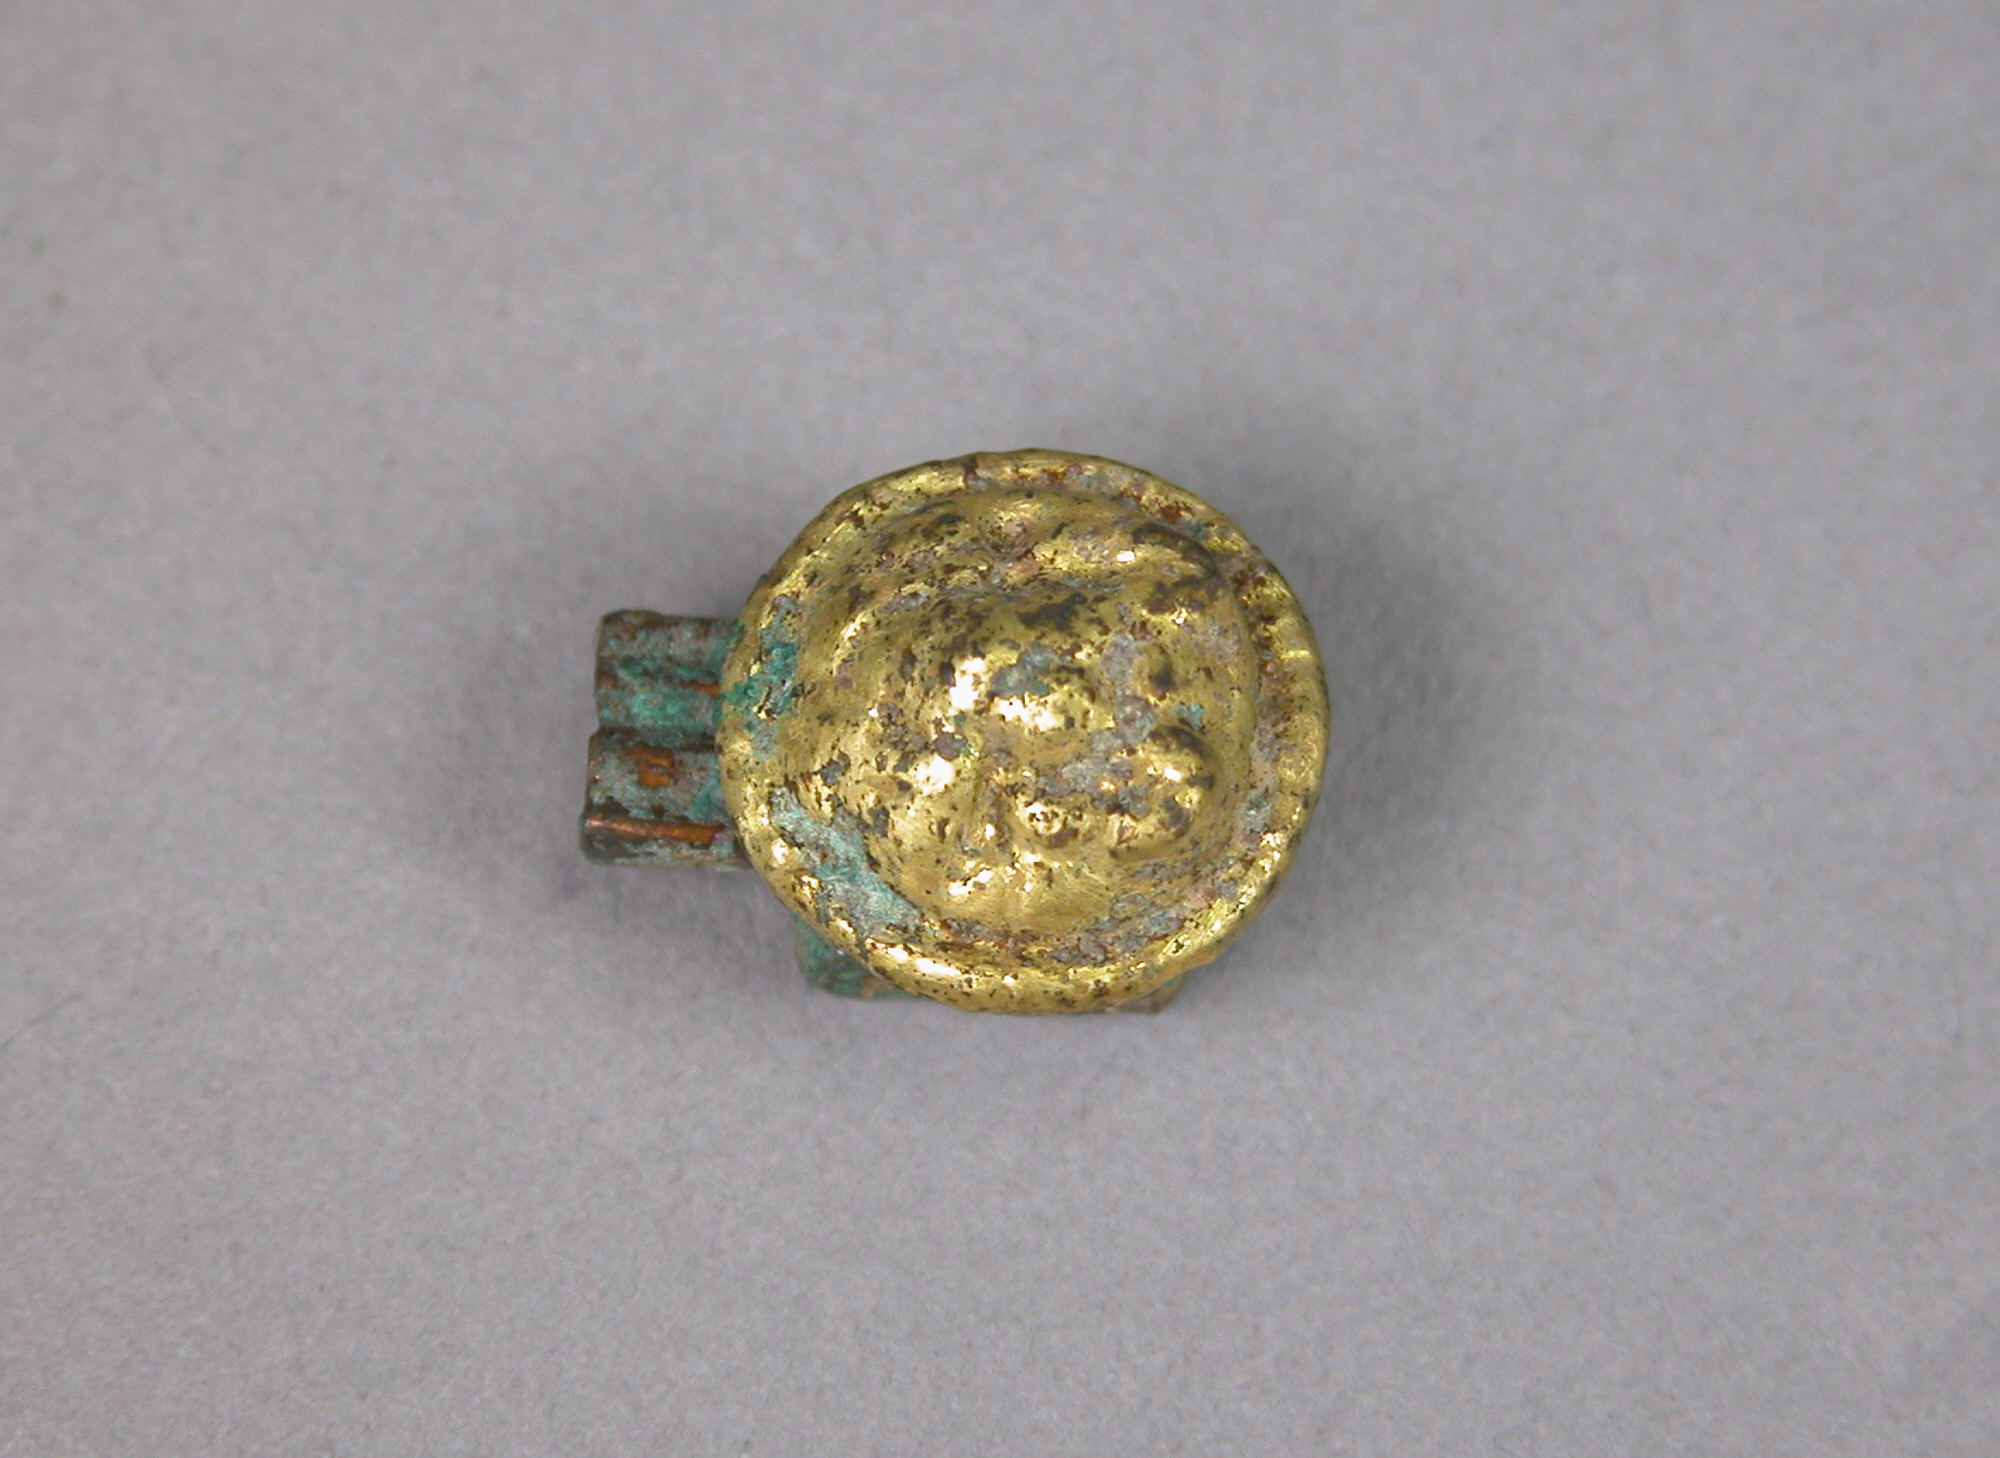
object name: ornament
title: Horse harness rosette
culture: chinese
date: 618-907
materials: gilt bronze